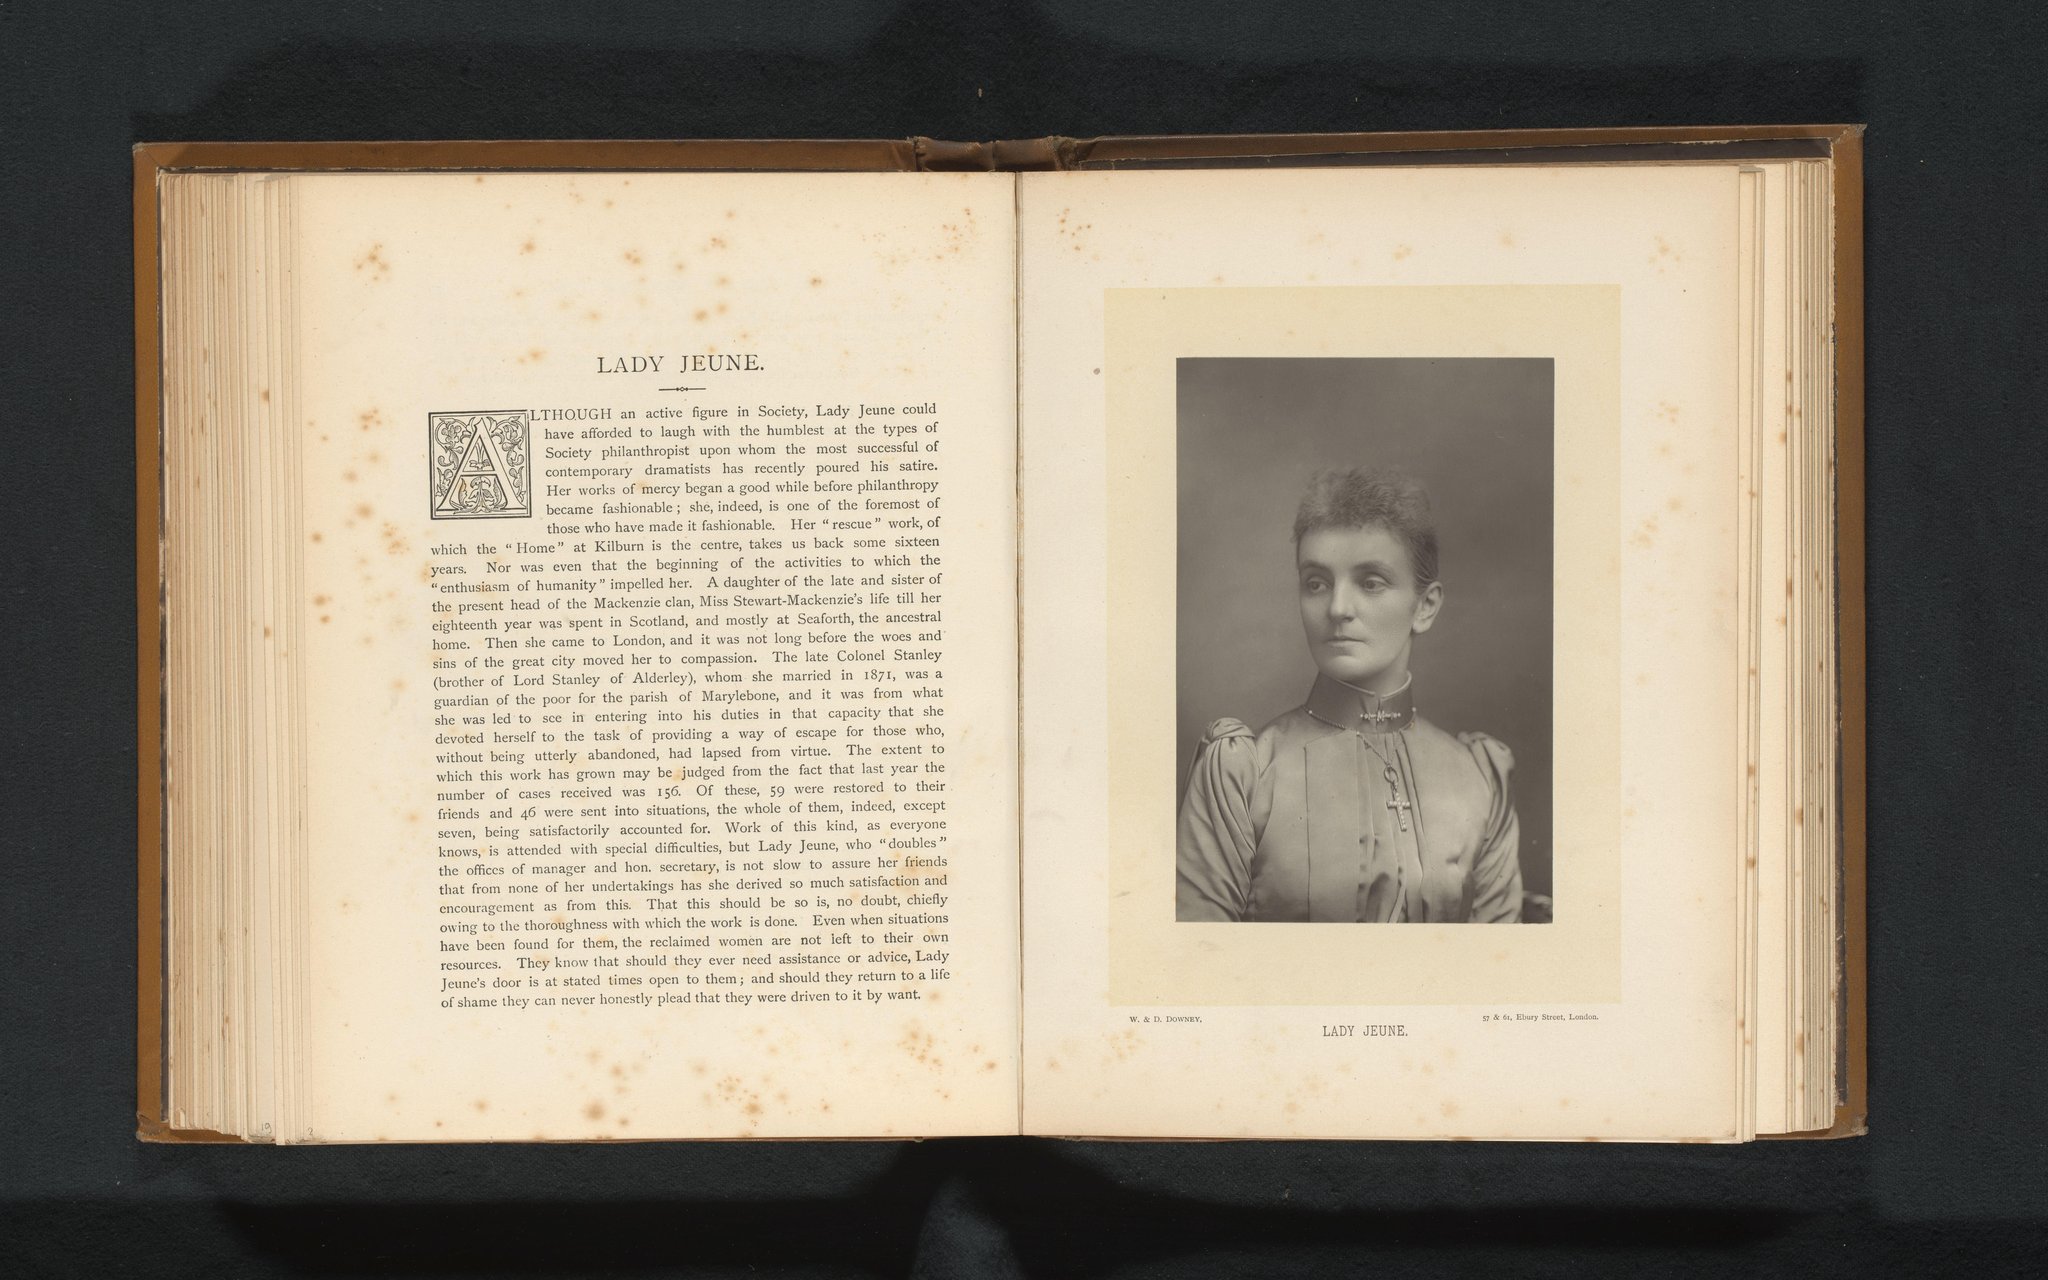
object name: page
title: Lady Jeune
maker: Anonymous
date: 1882-1892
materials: paper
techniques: woodburytype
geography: london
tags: politician, e.g. party leader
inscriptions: inscription: ‘57 & 61, Elbury Street, London.’